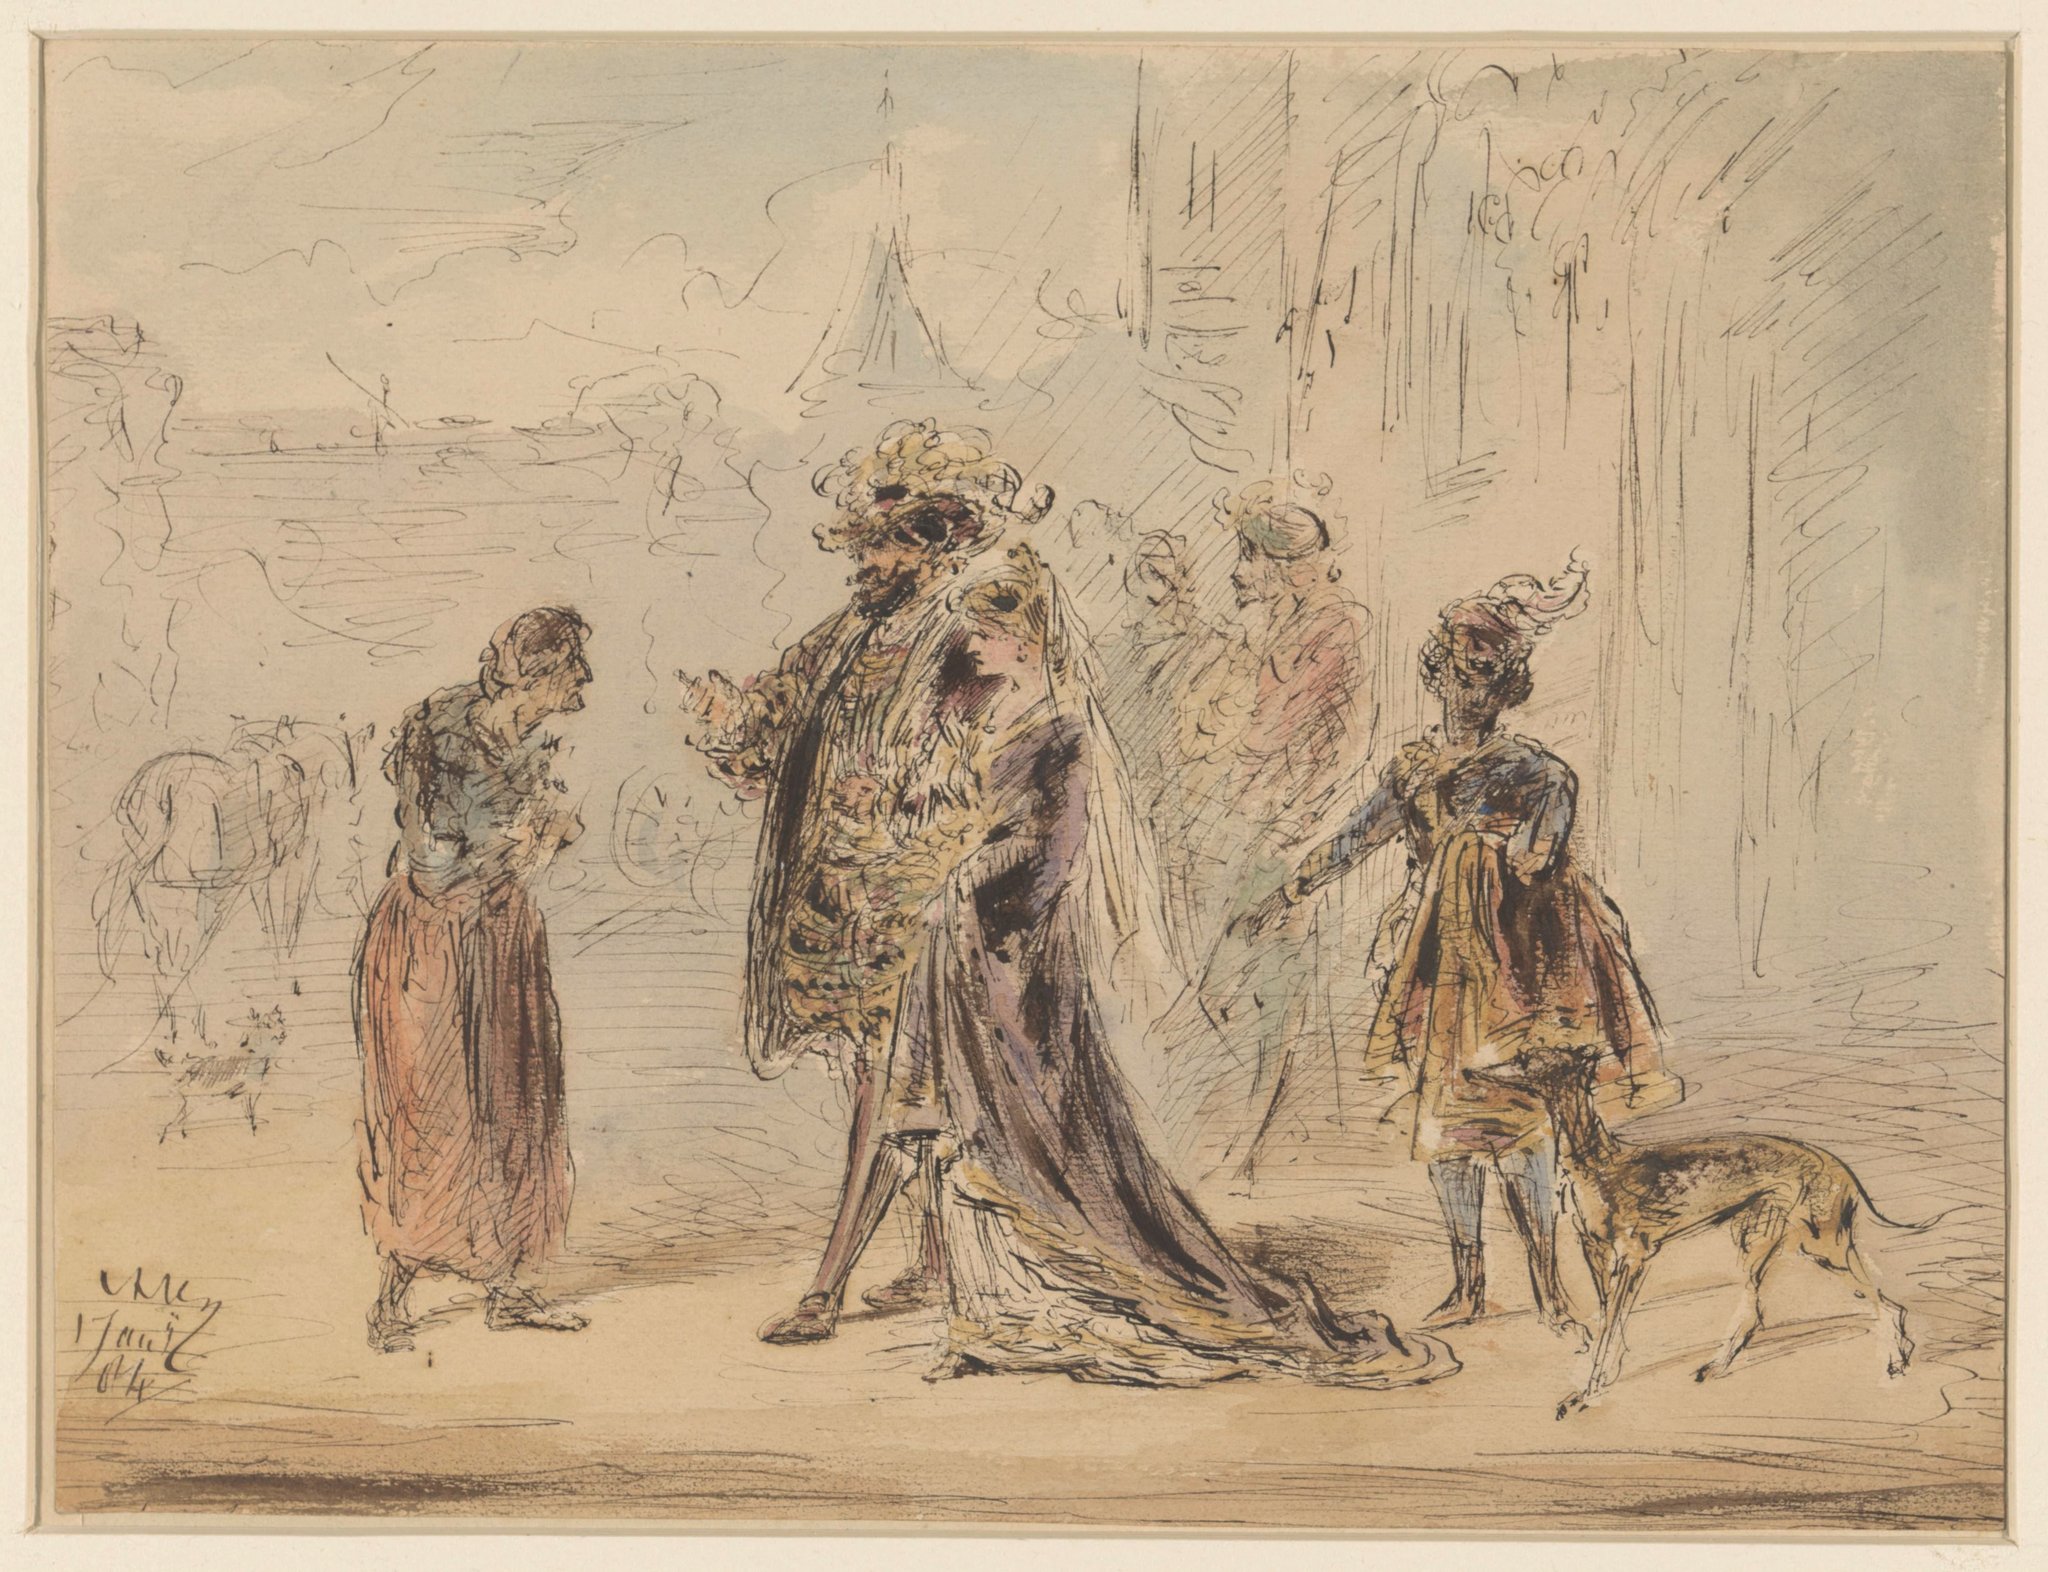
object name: drawing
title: Voorname man en vrouw in gesprek met een oude vrouw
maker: alexander ver huell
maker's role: draughtsman, print maker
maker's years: 1822-1897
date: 1884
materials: ink, paper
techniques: brush, pen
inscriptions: date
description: Voorname man en vrouw met dienstbode en jachthond in gesprek met een oude vrouw.